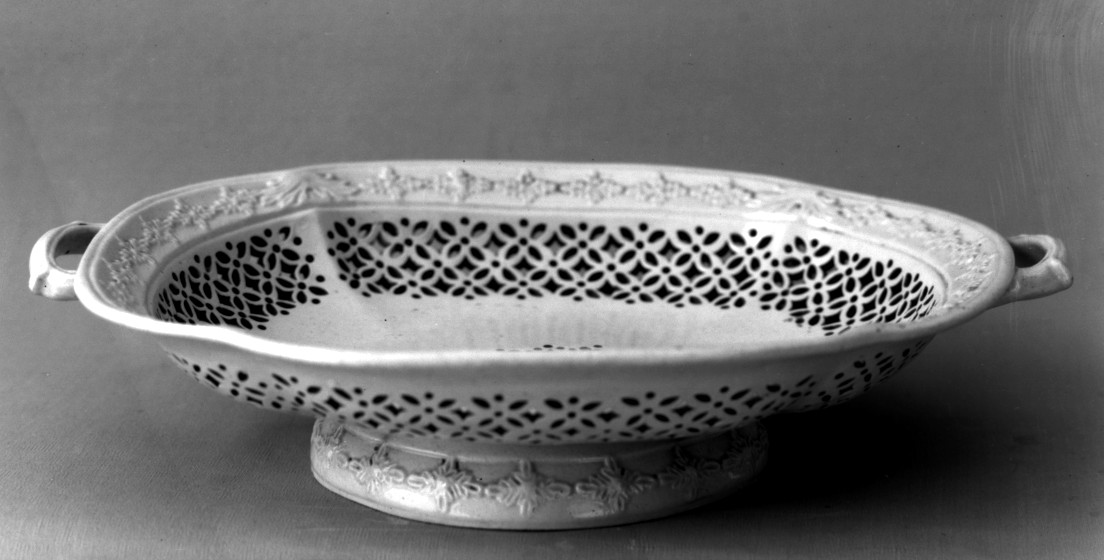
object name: fruit dish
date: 1760-1780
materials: stoneware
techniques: salt glaze